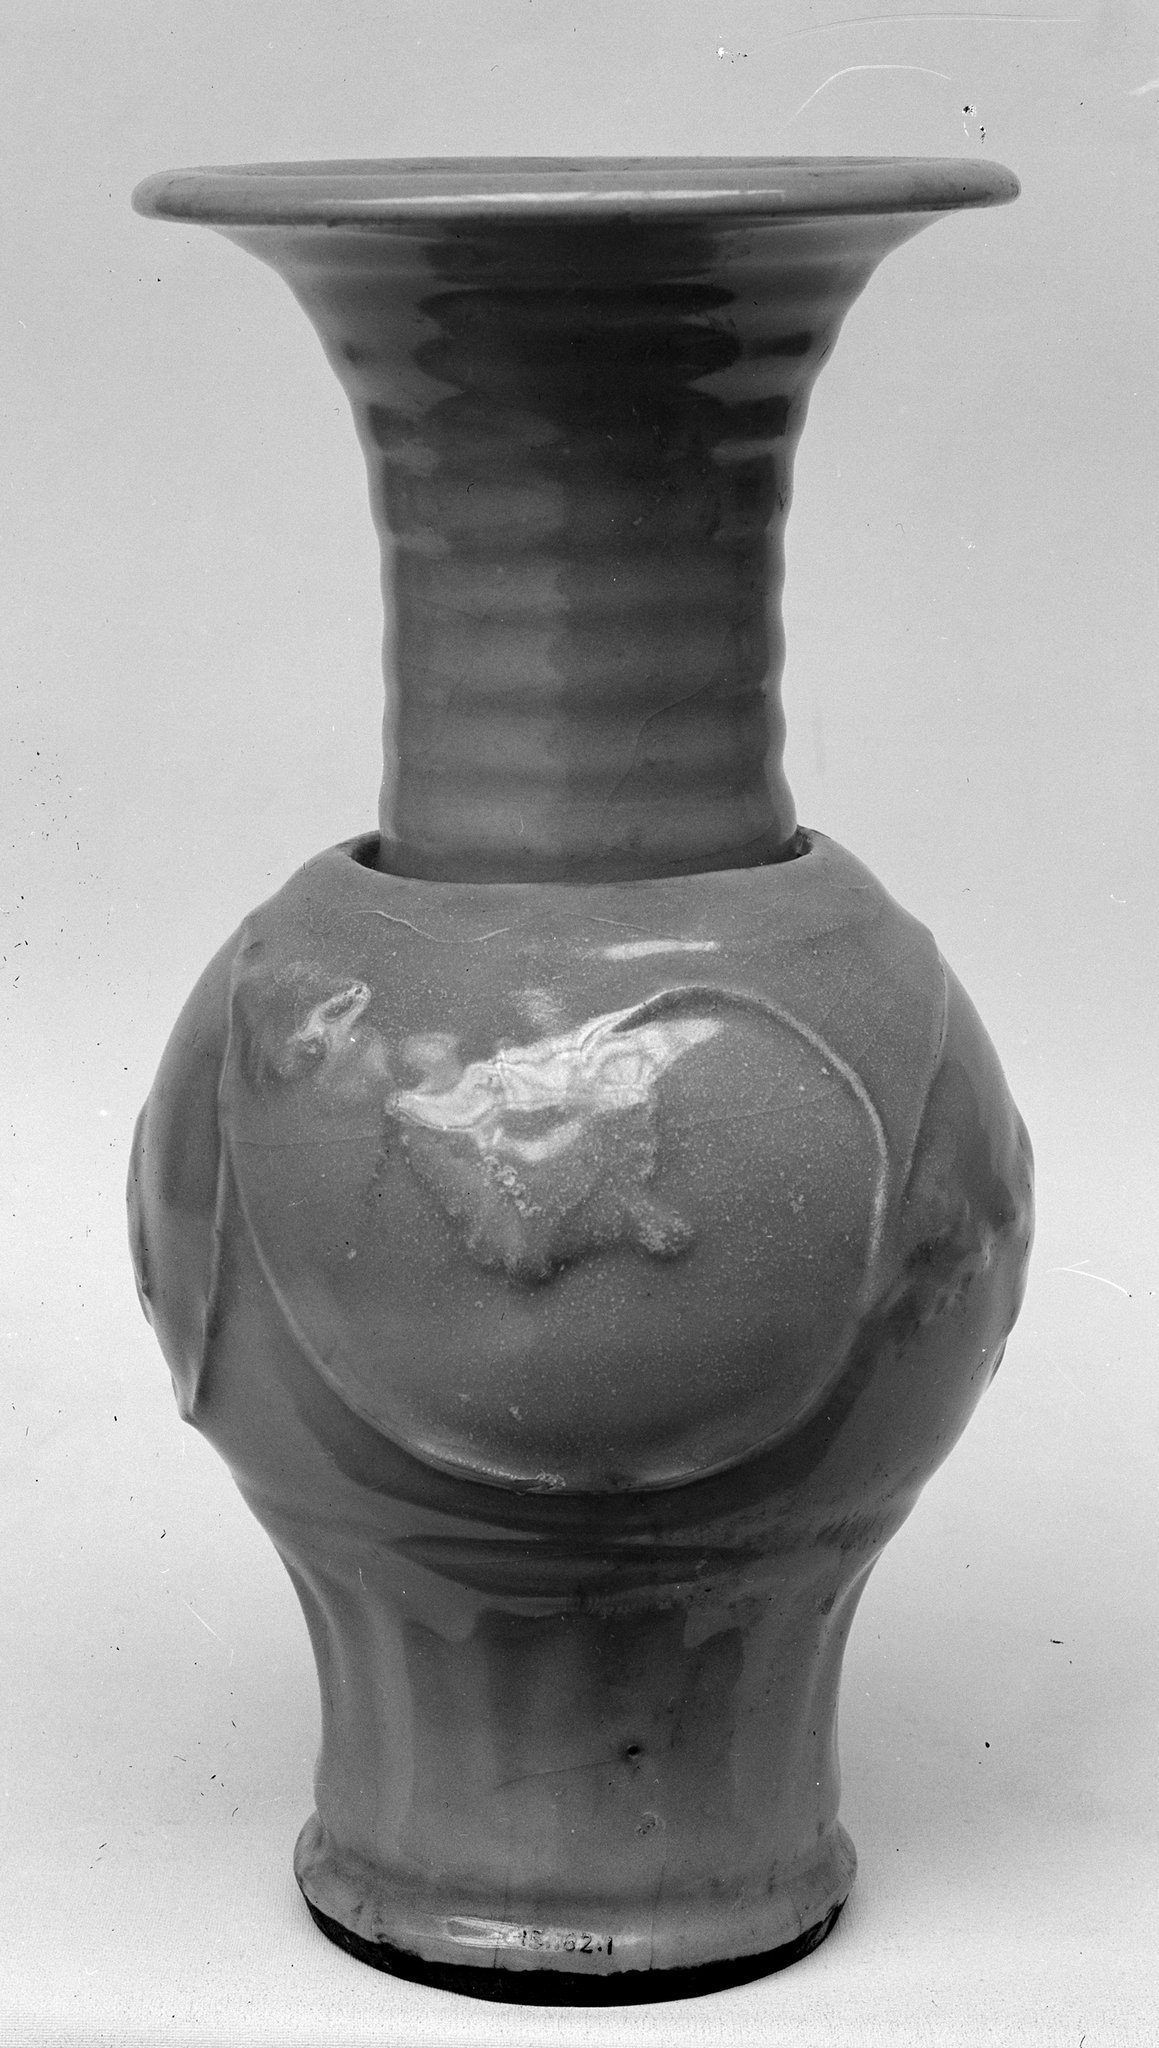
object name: vase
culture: chinese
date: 960-1279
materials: pottery